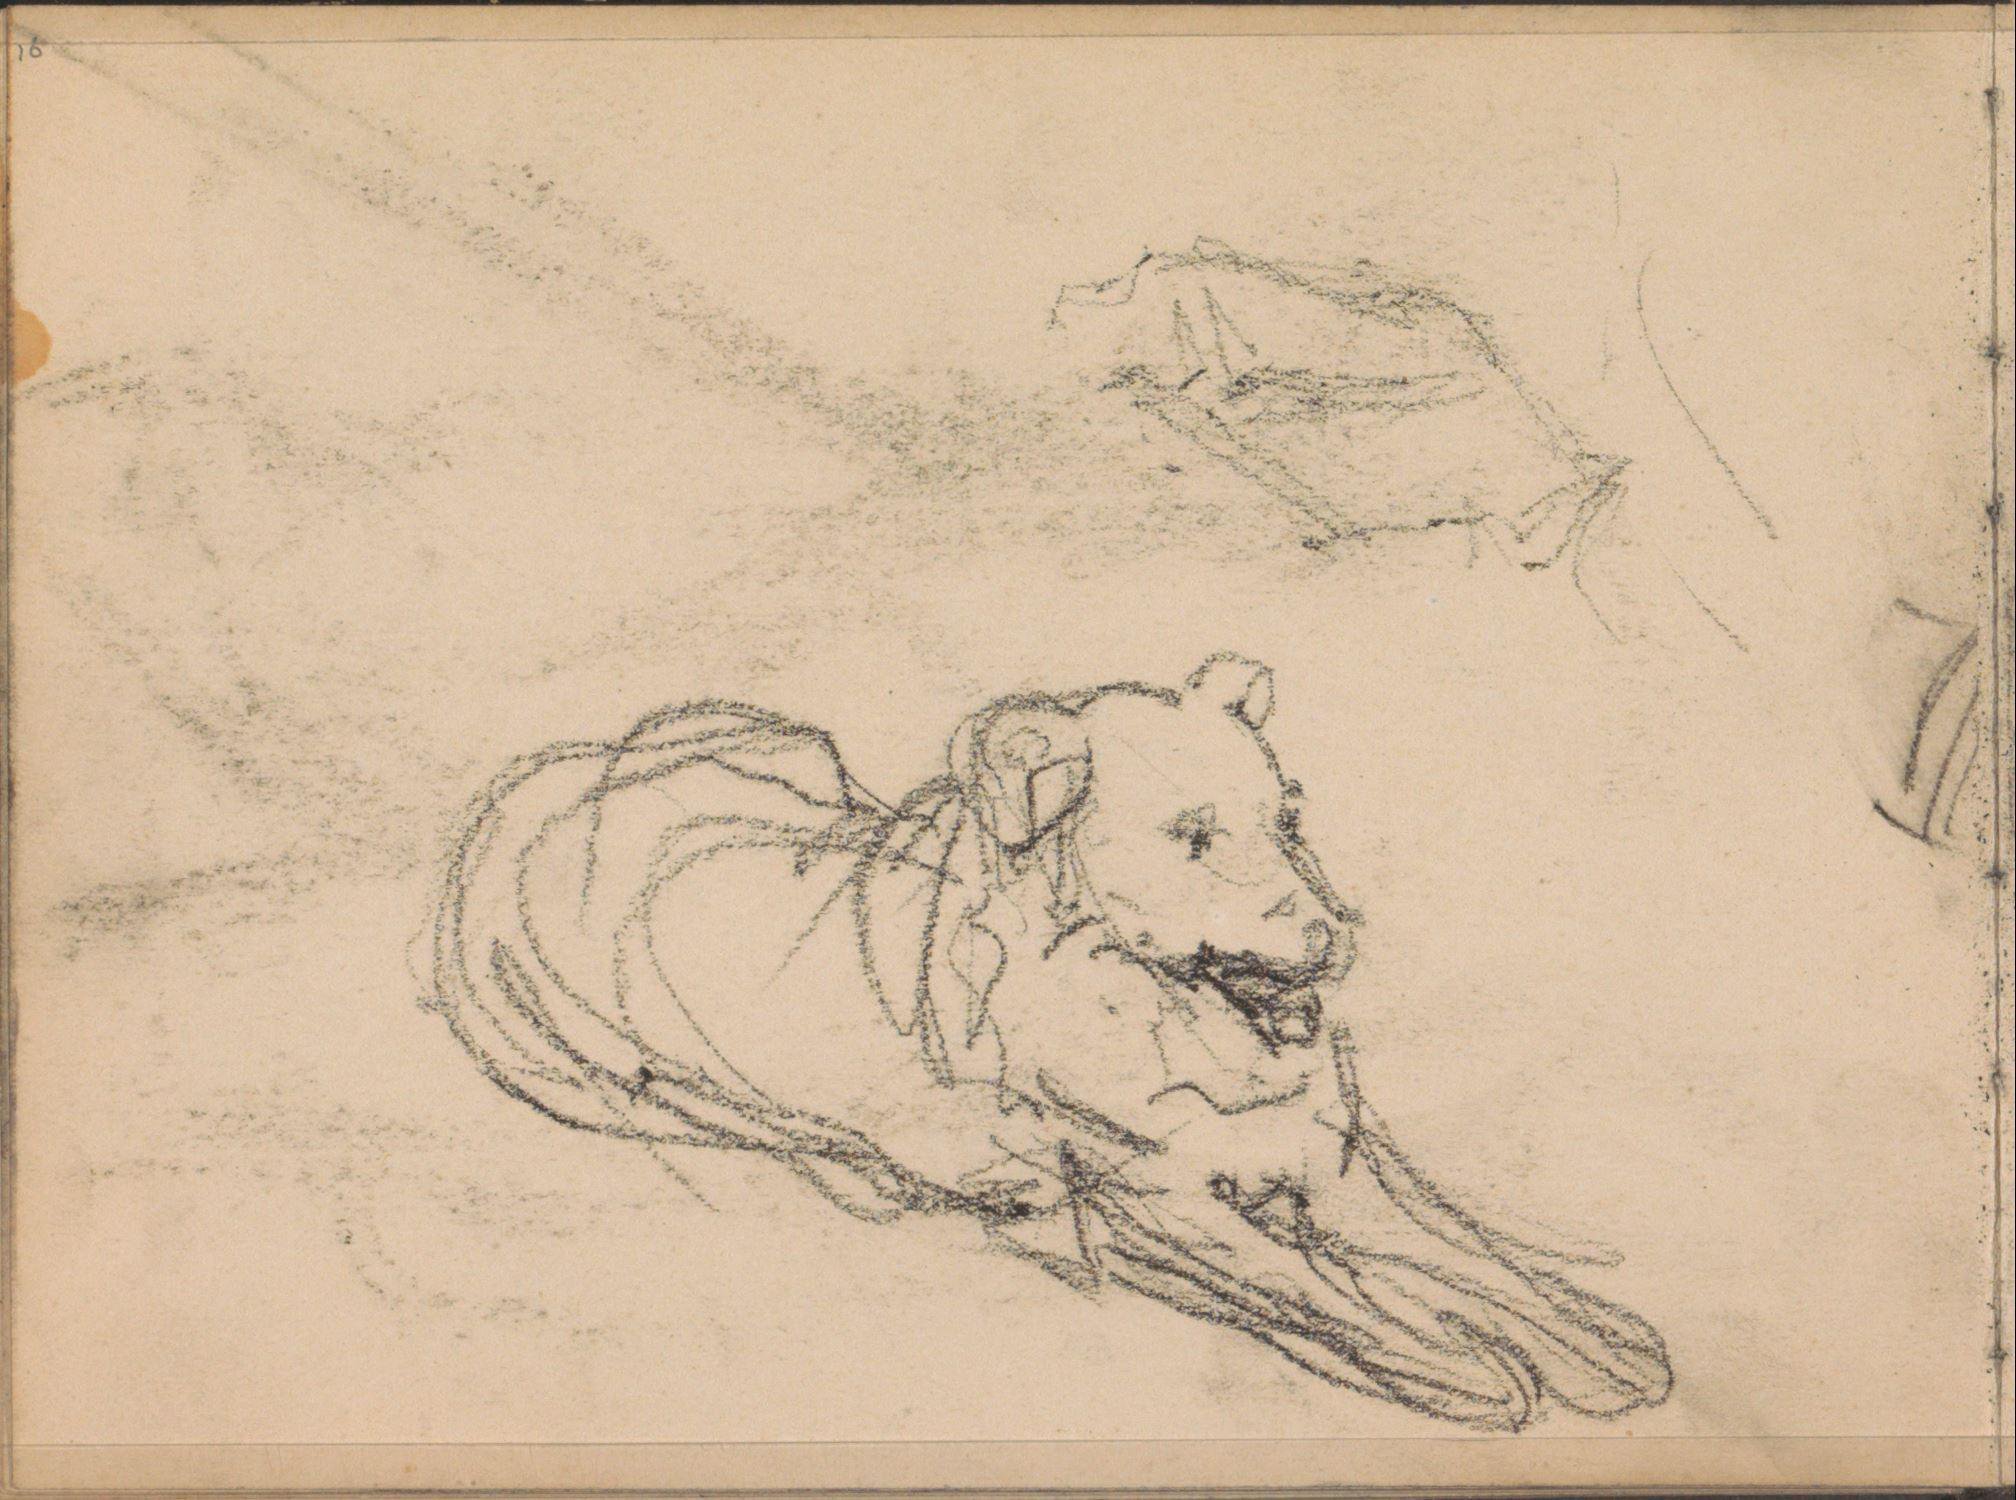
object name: sketchbook leaf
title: Liggende hond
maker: marius bauer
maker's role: draughtsman, print maker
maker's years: 1867-1932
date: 1879-1884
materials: chalk, paper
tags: dog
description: De hond ligt op de buik met de poten uitgestrekt. Pagina 16 uit een schetsboek met 28 bladen.